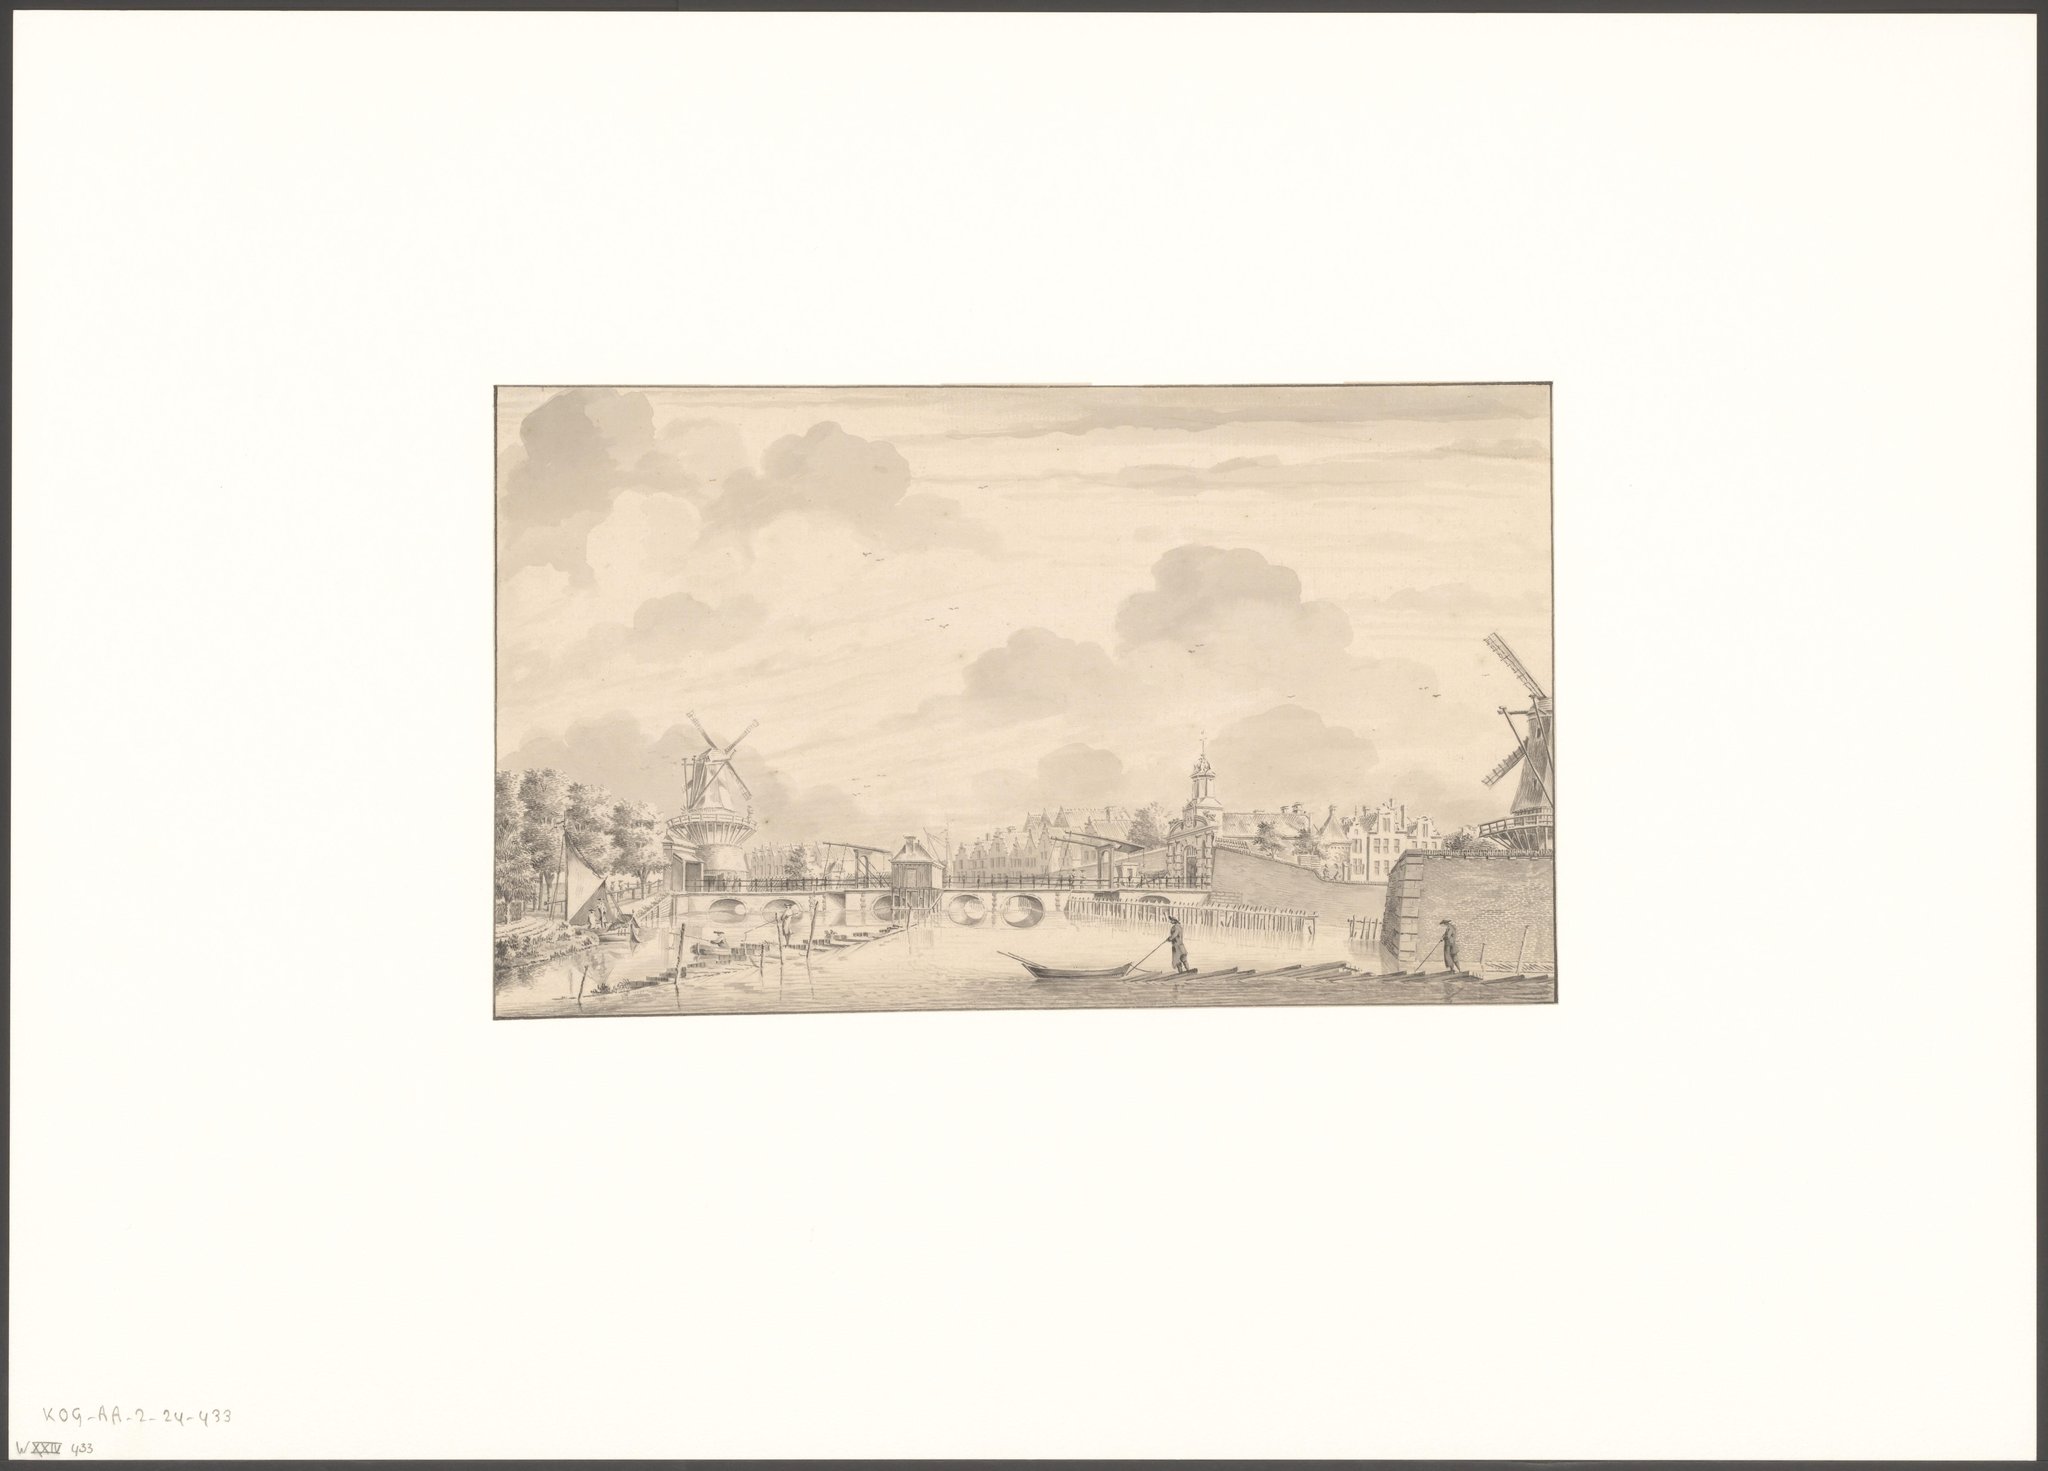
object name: drawing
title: Gezicht op de Haarlemmerpoort vanaf het Singel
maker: dirk verrijk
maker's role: draughtsman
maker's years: 1734-1786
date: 1744-1786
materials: ink, paper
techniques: brush, pen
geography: amsterdam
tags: city-view in general; 'veduta', canal, windmill in landscape, bridge in city across river, canal, etc., city-gate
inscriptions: collector's mark: Lugt 800a, inscription: ‘Atlas Hartkamp. 136’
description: Tekening binnen de Atlas Van Eck ingedeeld op wijknummer 24.